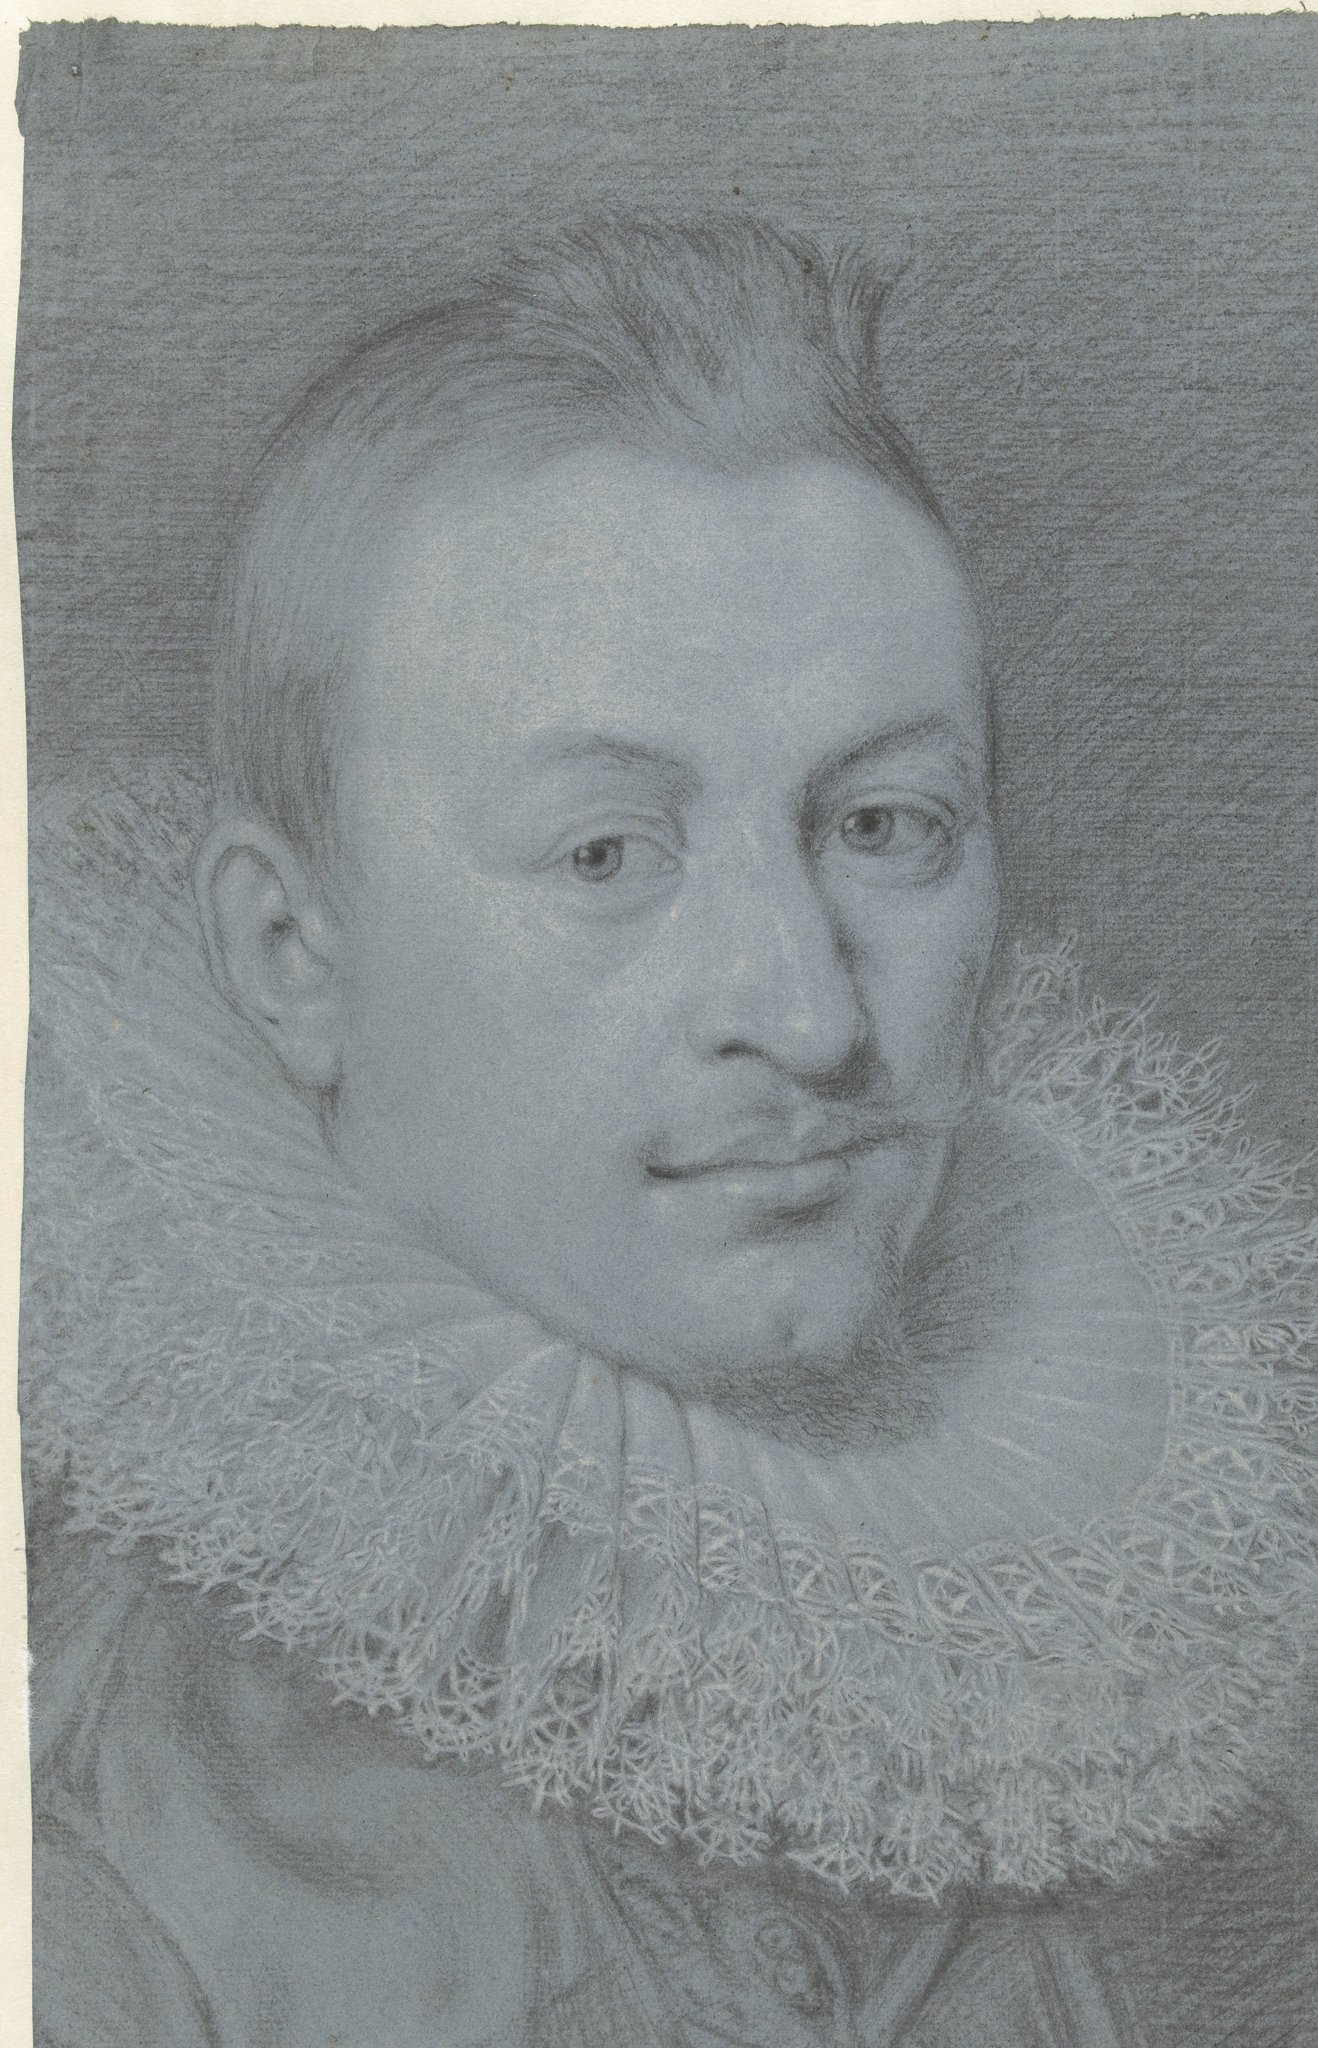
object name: drawing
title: Mansportret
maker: jordanus hoorn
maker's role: draughtsman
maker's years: 1753-1833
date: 1763-1833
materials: chalk, paper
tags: anonymous historical person portrayed alone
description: Naar een schilderij van Paulus Moreelse.